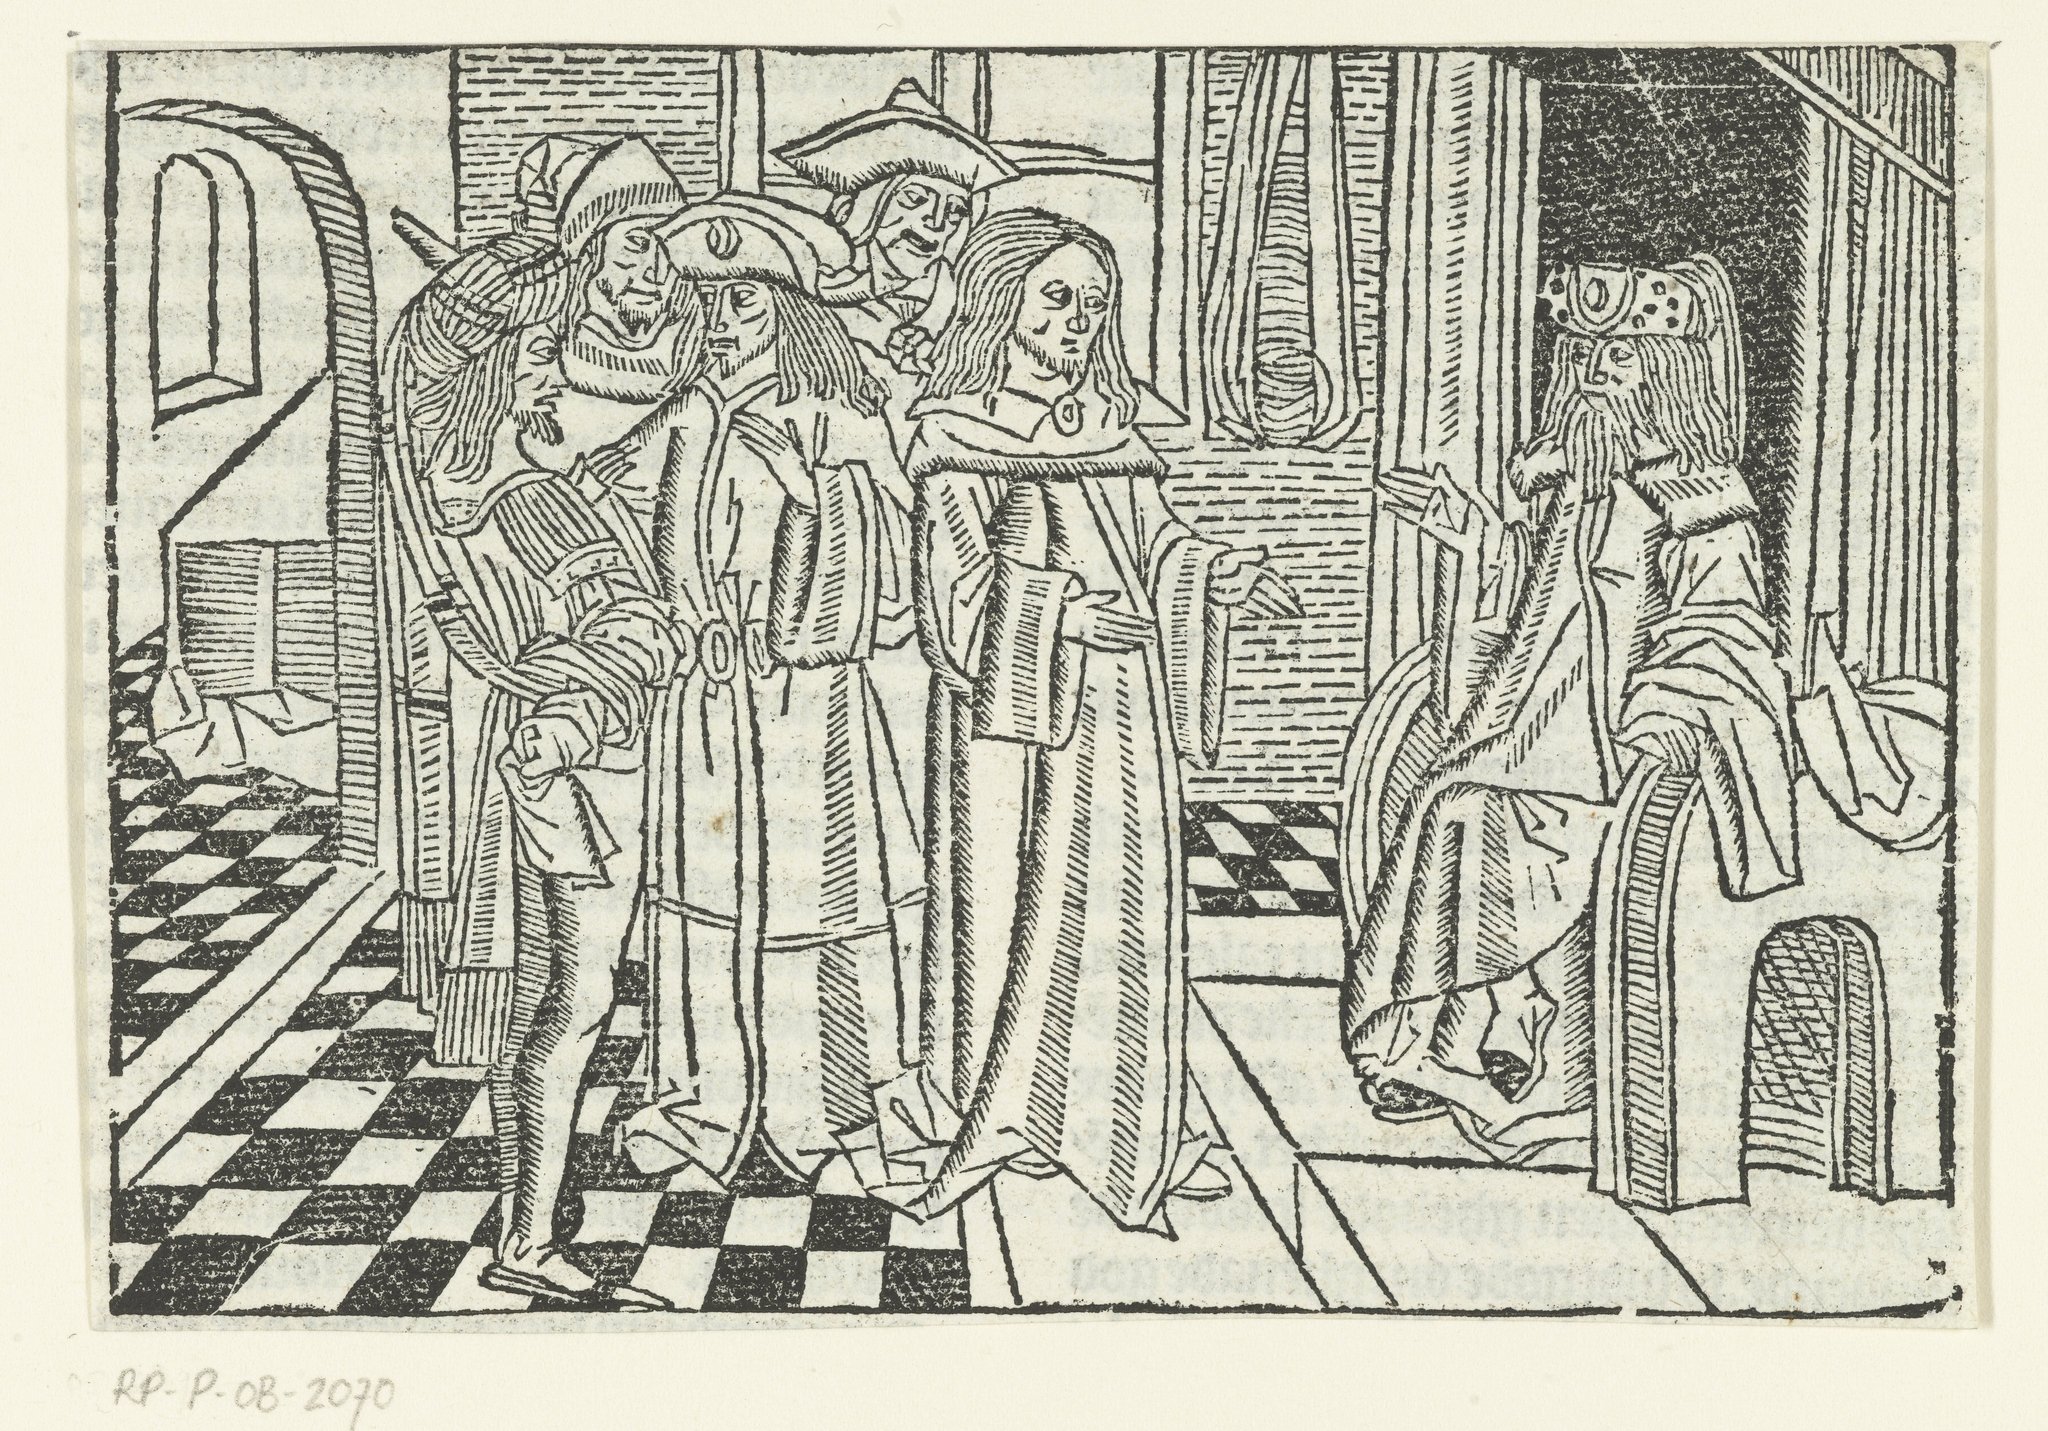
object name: book illustration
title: Parabel van de koning die rekenschap vraagt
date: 1480-1500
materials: paper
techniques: woodcut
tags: the unmerciful servant: the king forgives him his debts ~ parable of christ (matthew 18:23-35)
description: Eén blad van 113 uit Ludolphus de Saxonia, "Dit es dleué ons liefs heeren ihesu christi". Anonieme Nederlandse vertaling. Uitgegeven door Henrick Eckert van Homberch te Antwerpen in 1503. Botke, K. Deze 113 houtsneden, die meestal reeds in vroege Nederlandse boeken gebruikt zijn, worden toegeschreven aan de tweede Meester van Delft, de Meester van de Delbecq-Schreiber-passie en de Meester van de Virgo inter Virgines. In Conway (1884) en in "De gulden passer"(1951) zijn ook eerdere versies opgenomen. Botke, K.